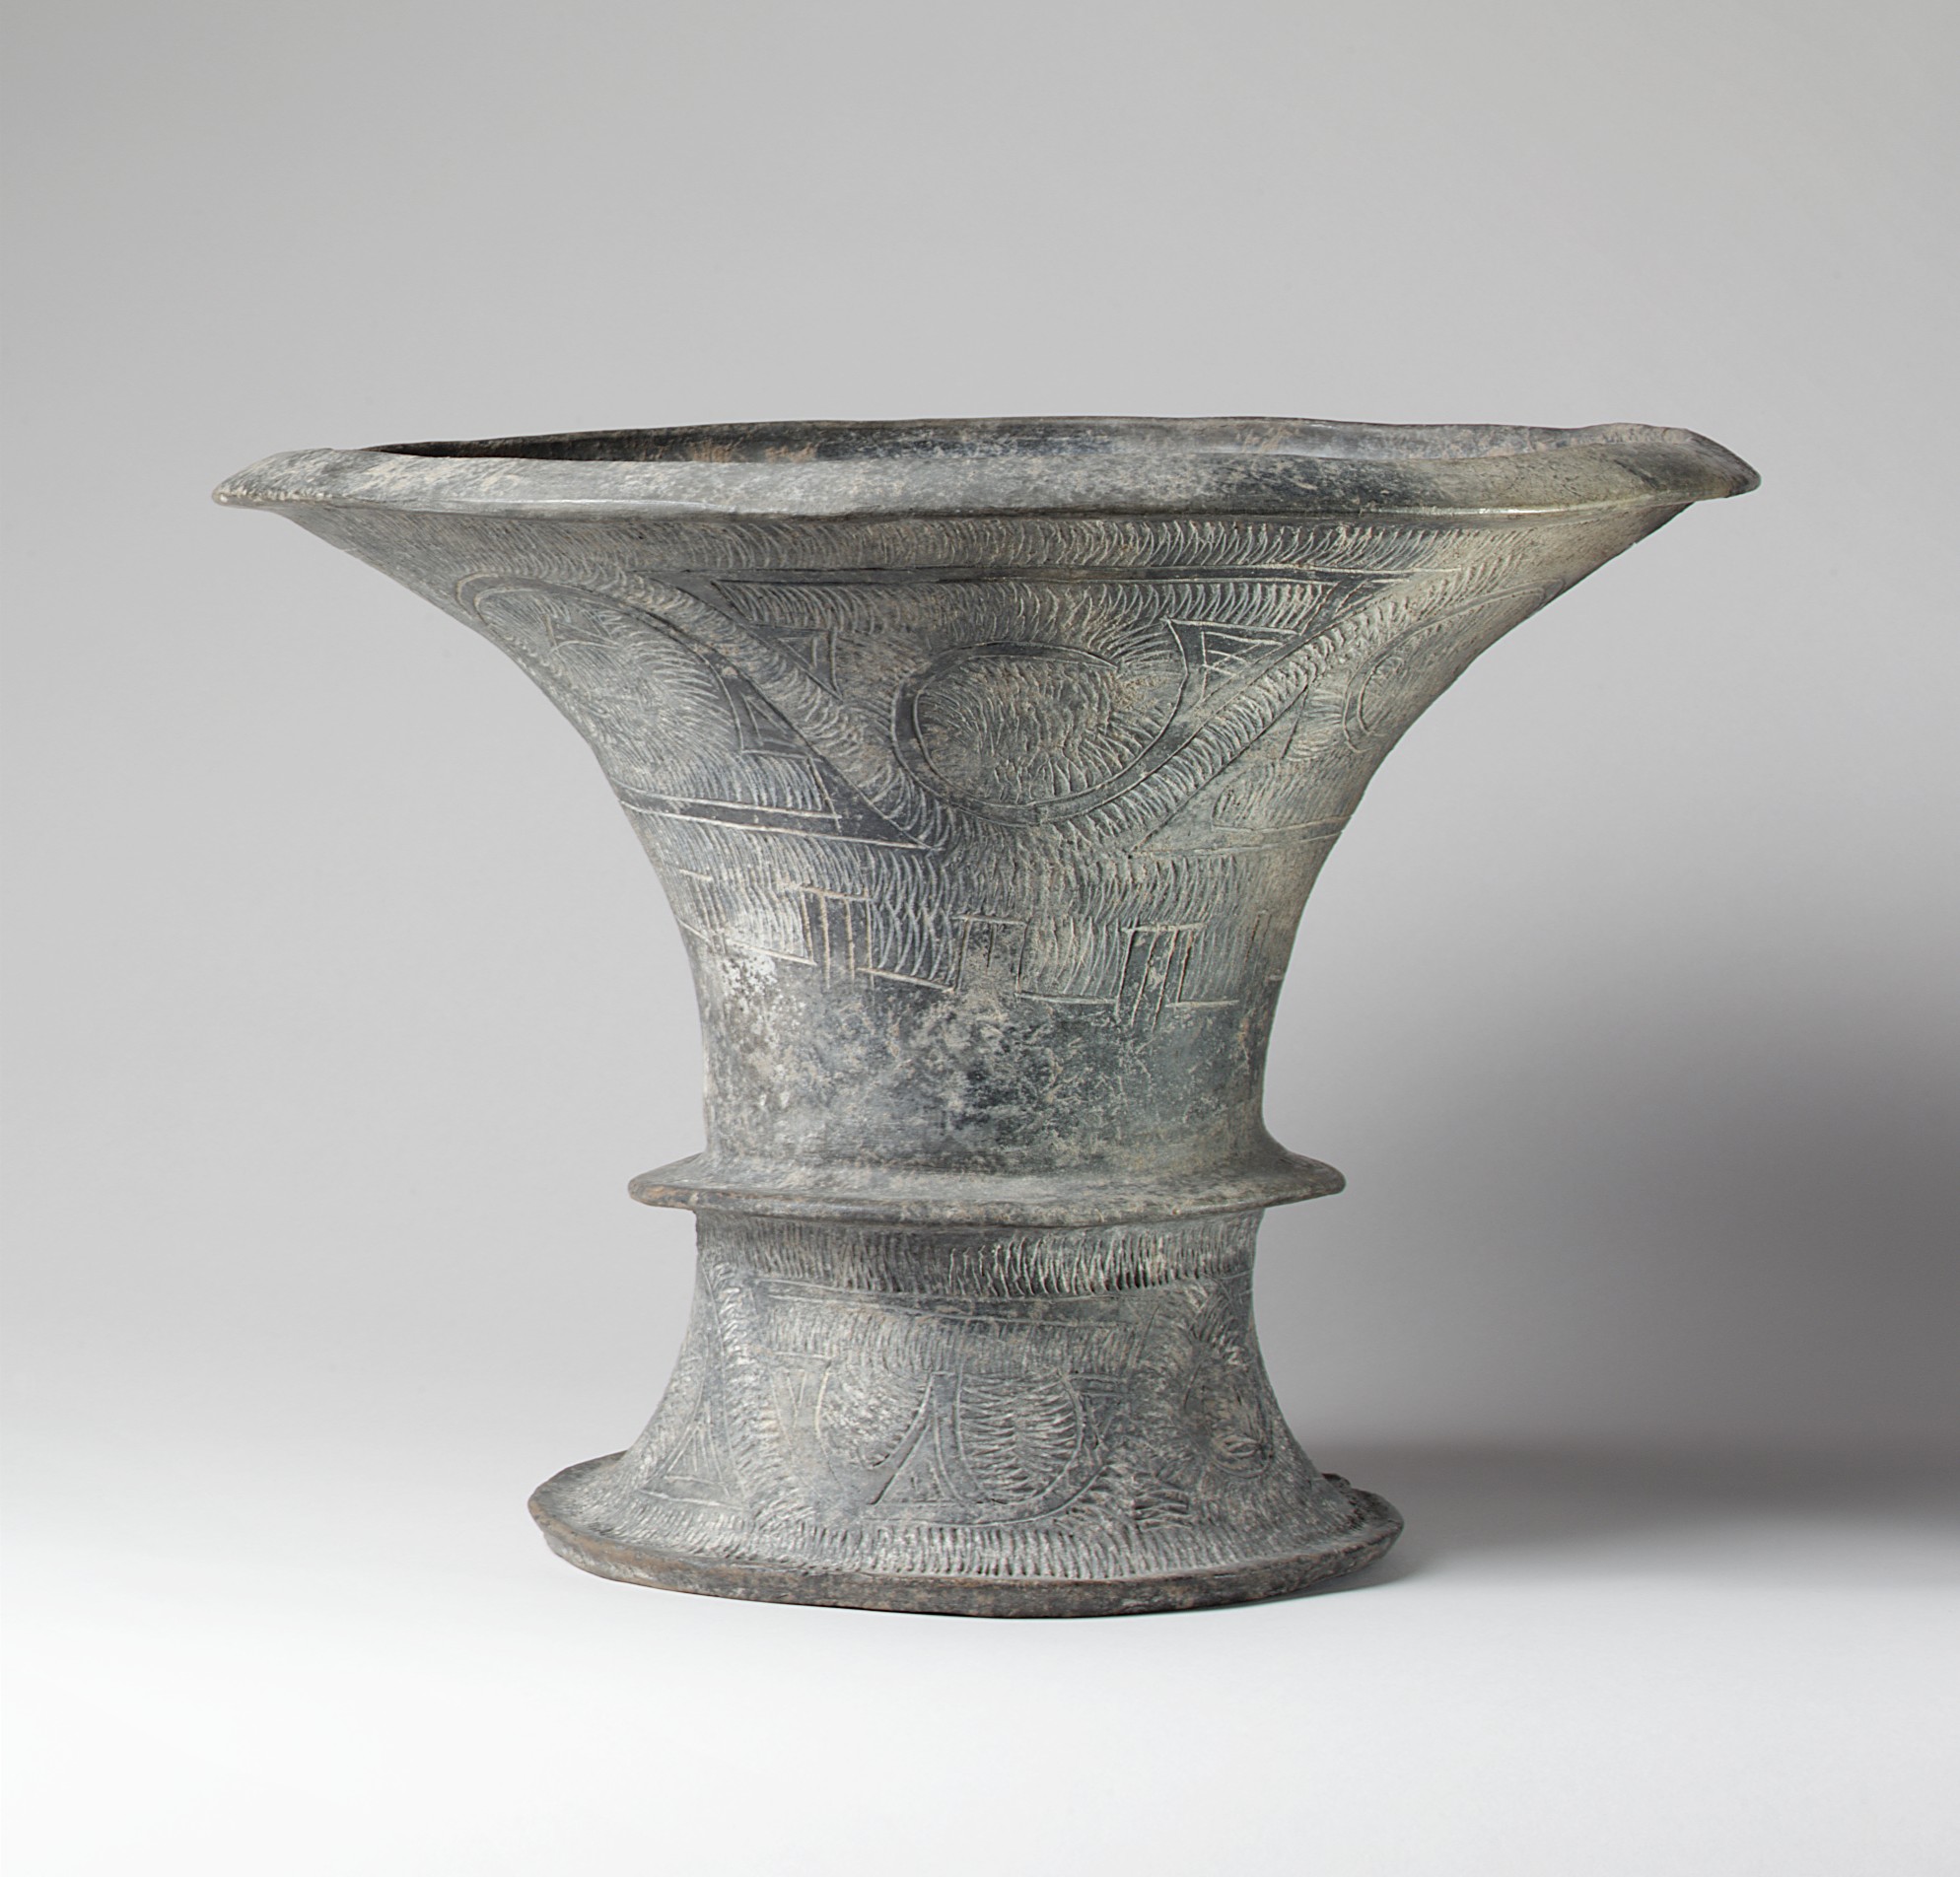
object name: vase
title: Vase with Incised and Impressed Designs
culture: thai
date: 3600-1000 BCE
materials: earthenware